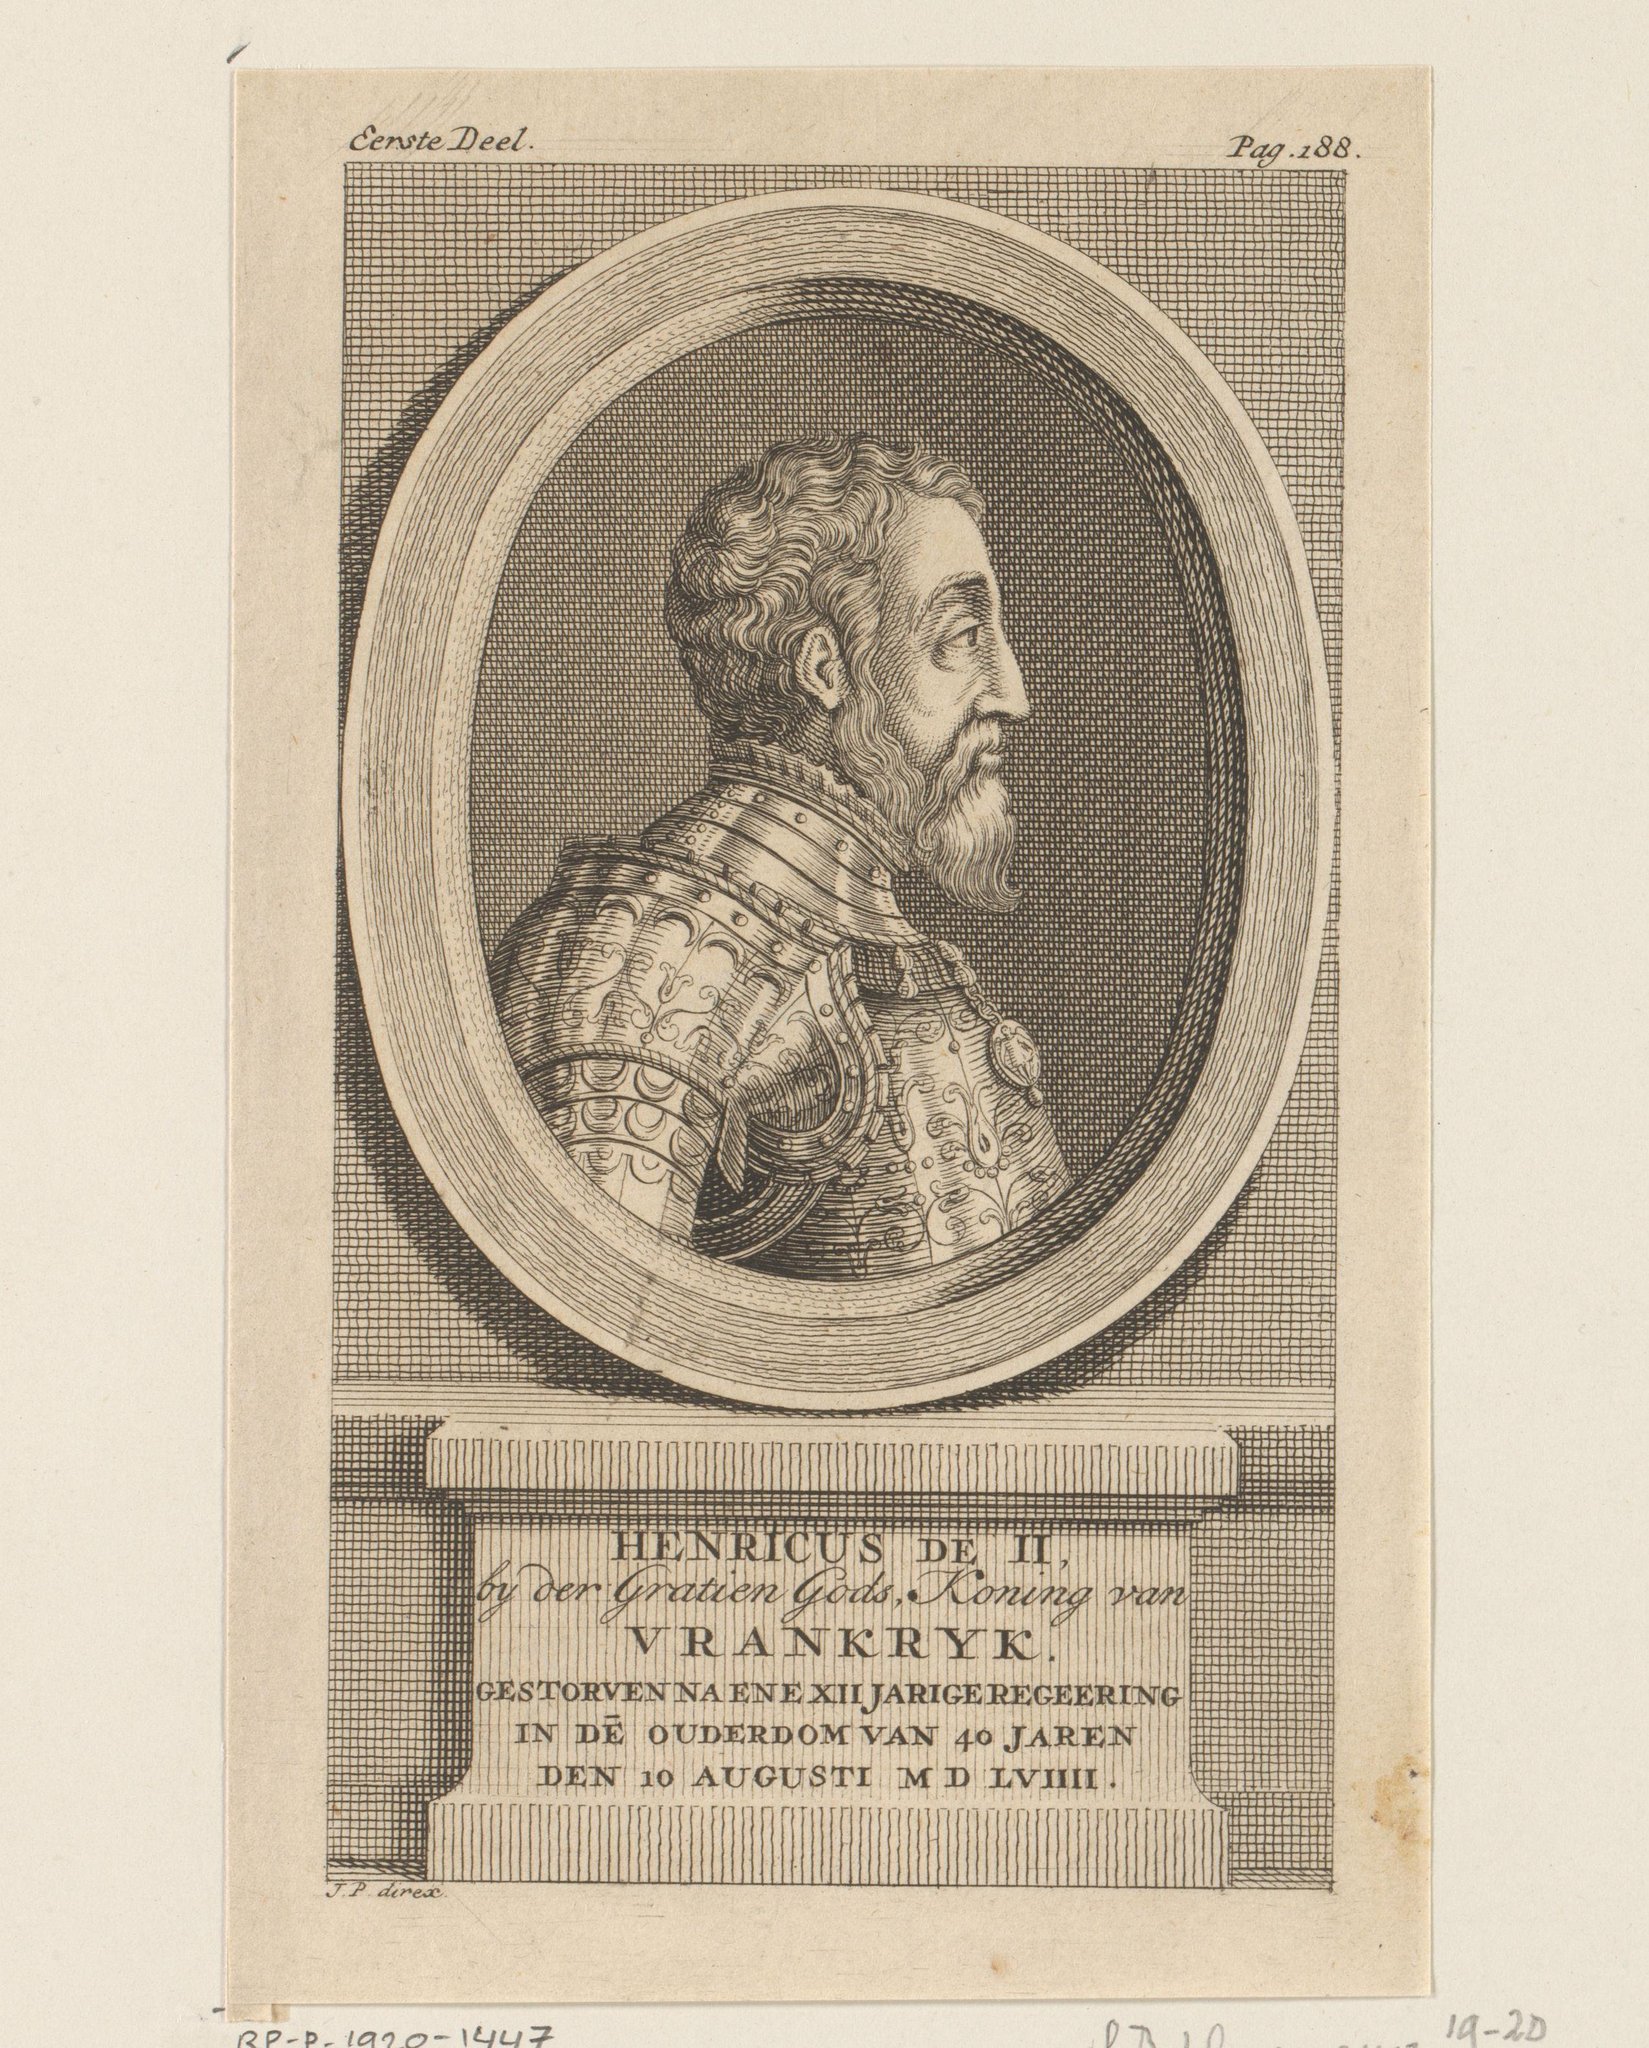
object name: print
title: Portret van Hendrik II, koning van Frankrijk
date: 1748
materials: paper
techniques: engraving, etching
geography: gorinchem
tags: armour, historical persons, king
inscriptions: collector's mark: Lugt 2228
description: Prent uit: Meteren, Emanuel van. Historie van de oorlogen en geschiedenissen der Nederlanderen, en der zelver naburen: (...). Gorinchem: Nicolaas Goetzee, 1748, dl. 1.